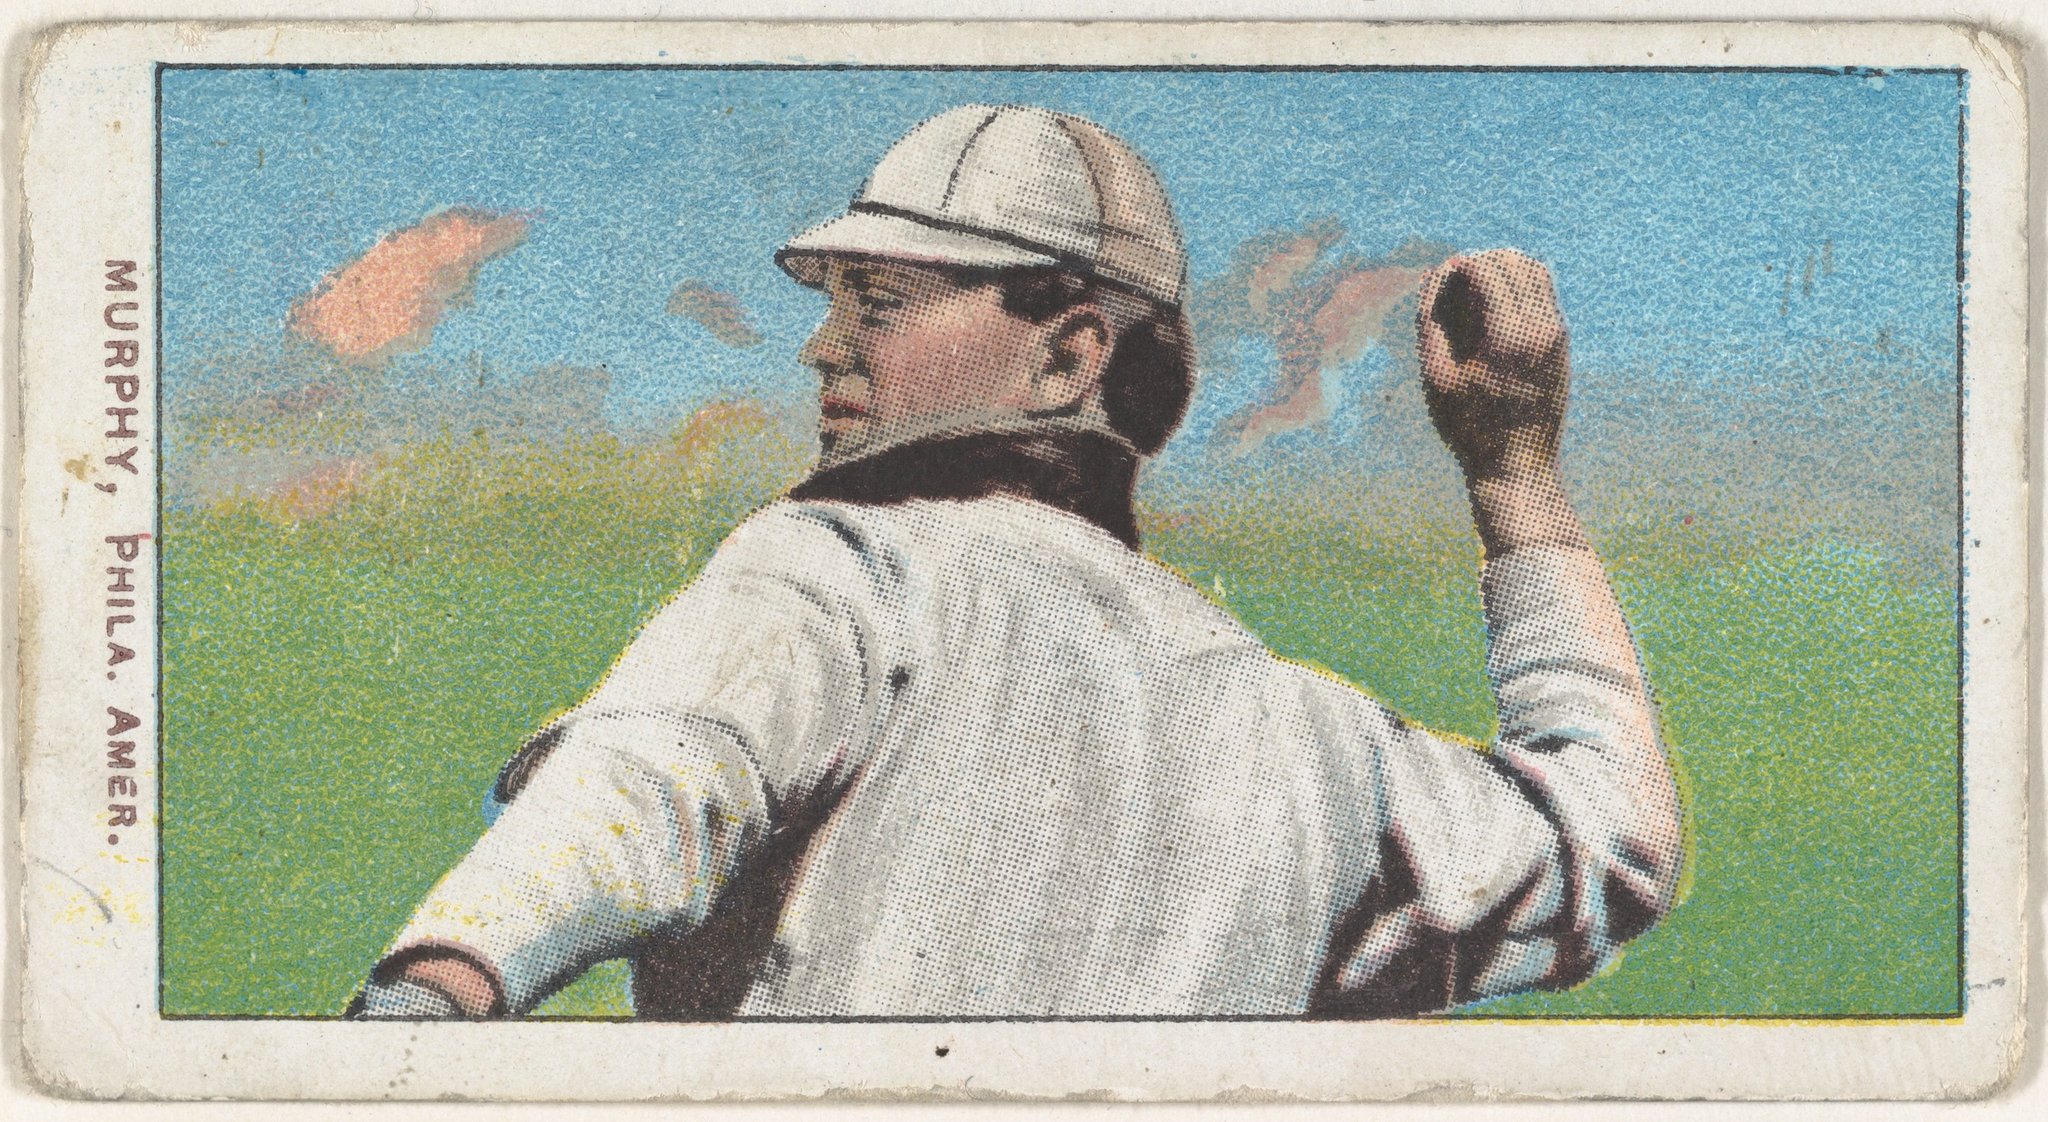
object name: baseball card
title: Murphy, Philadelphia, American League, from the White Border series (T206) for the American Tobacco Company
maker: american tobacco company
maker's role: publisher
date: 1909-1911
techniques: color lithograph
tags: men,baseball,athletes